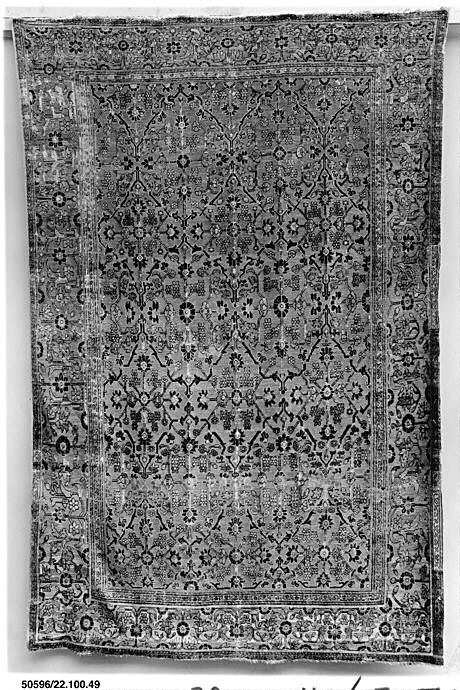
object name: carpet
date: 1701-1800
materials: silk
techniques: asymmetrically knotted pile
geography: china